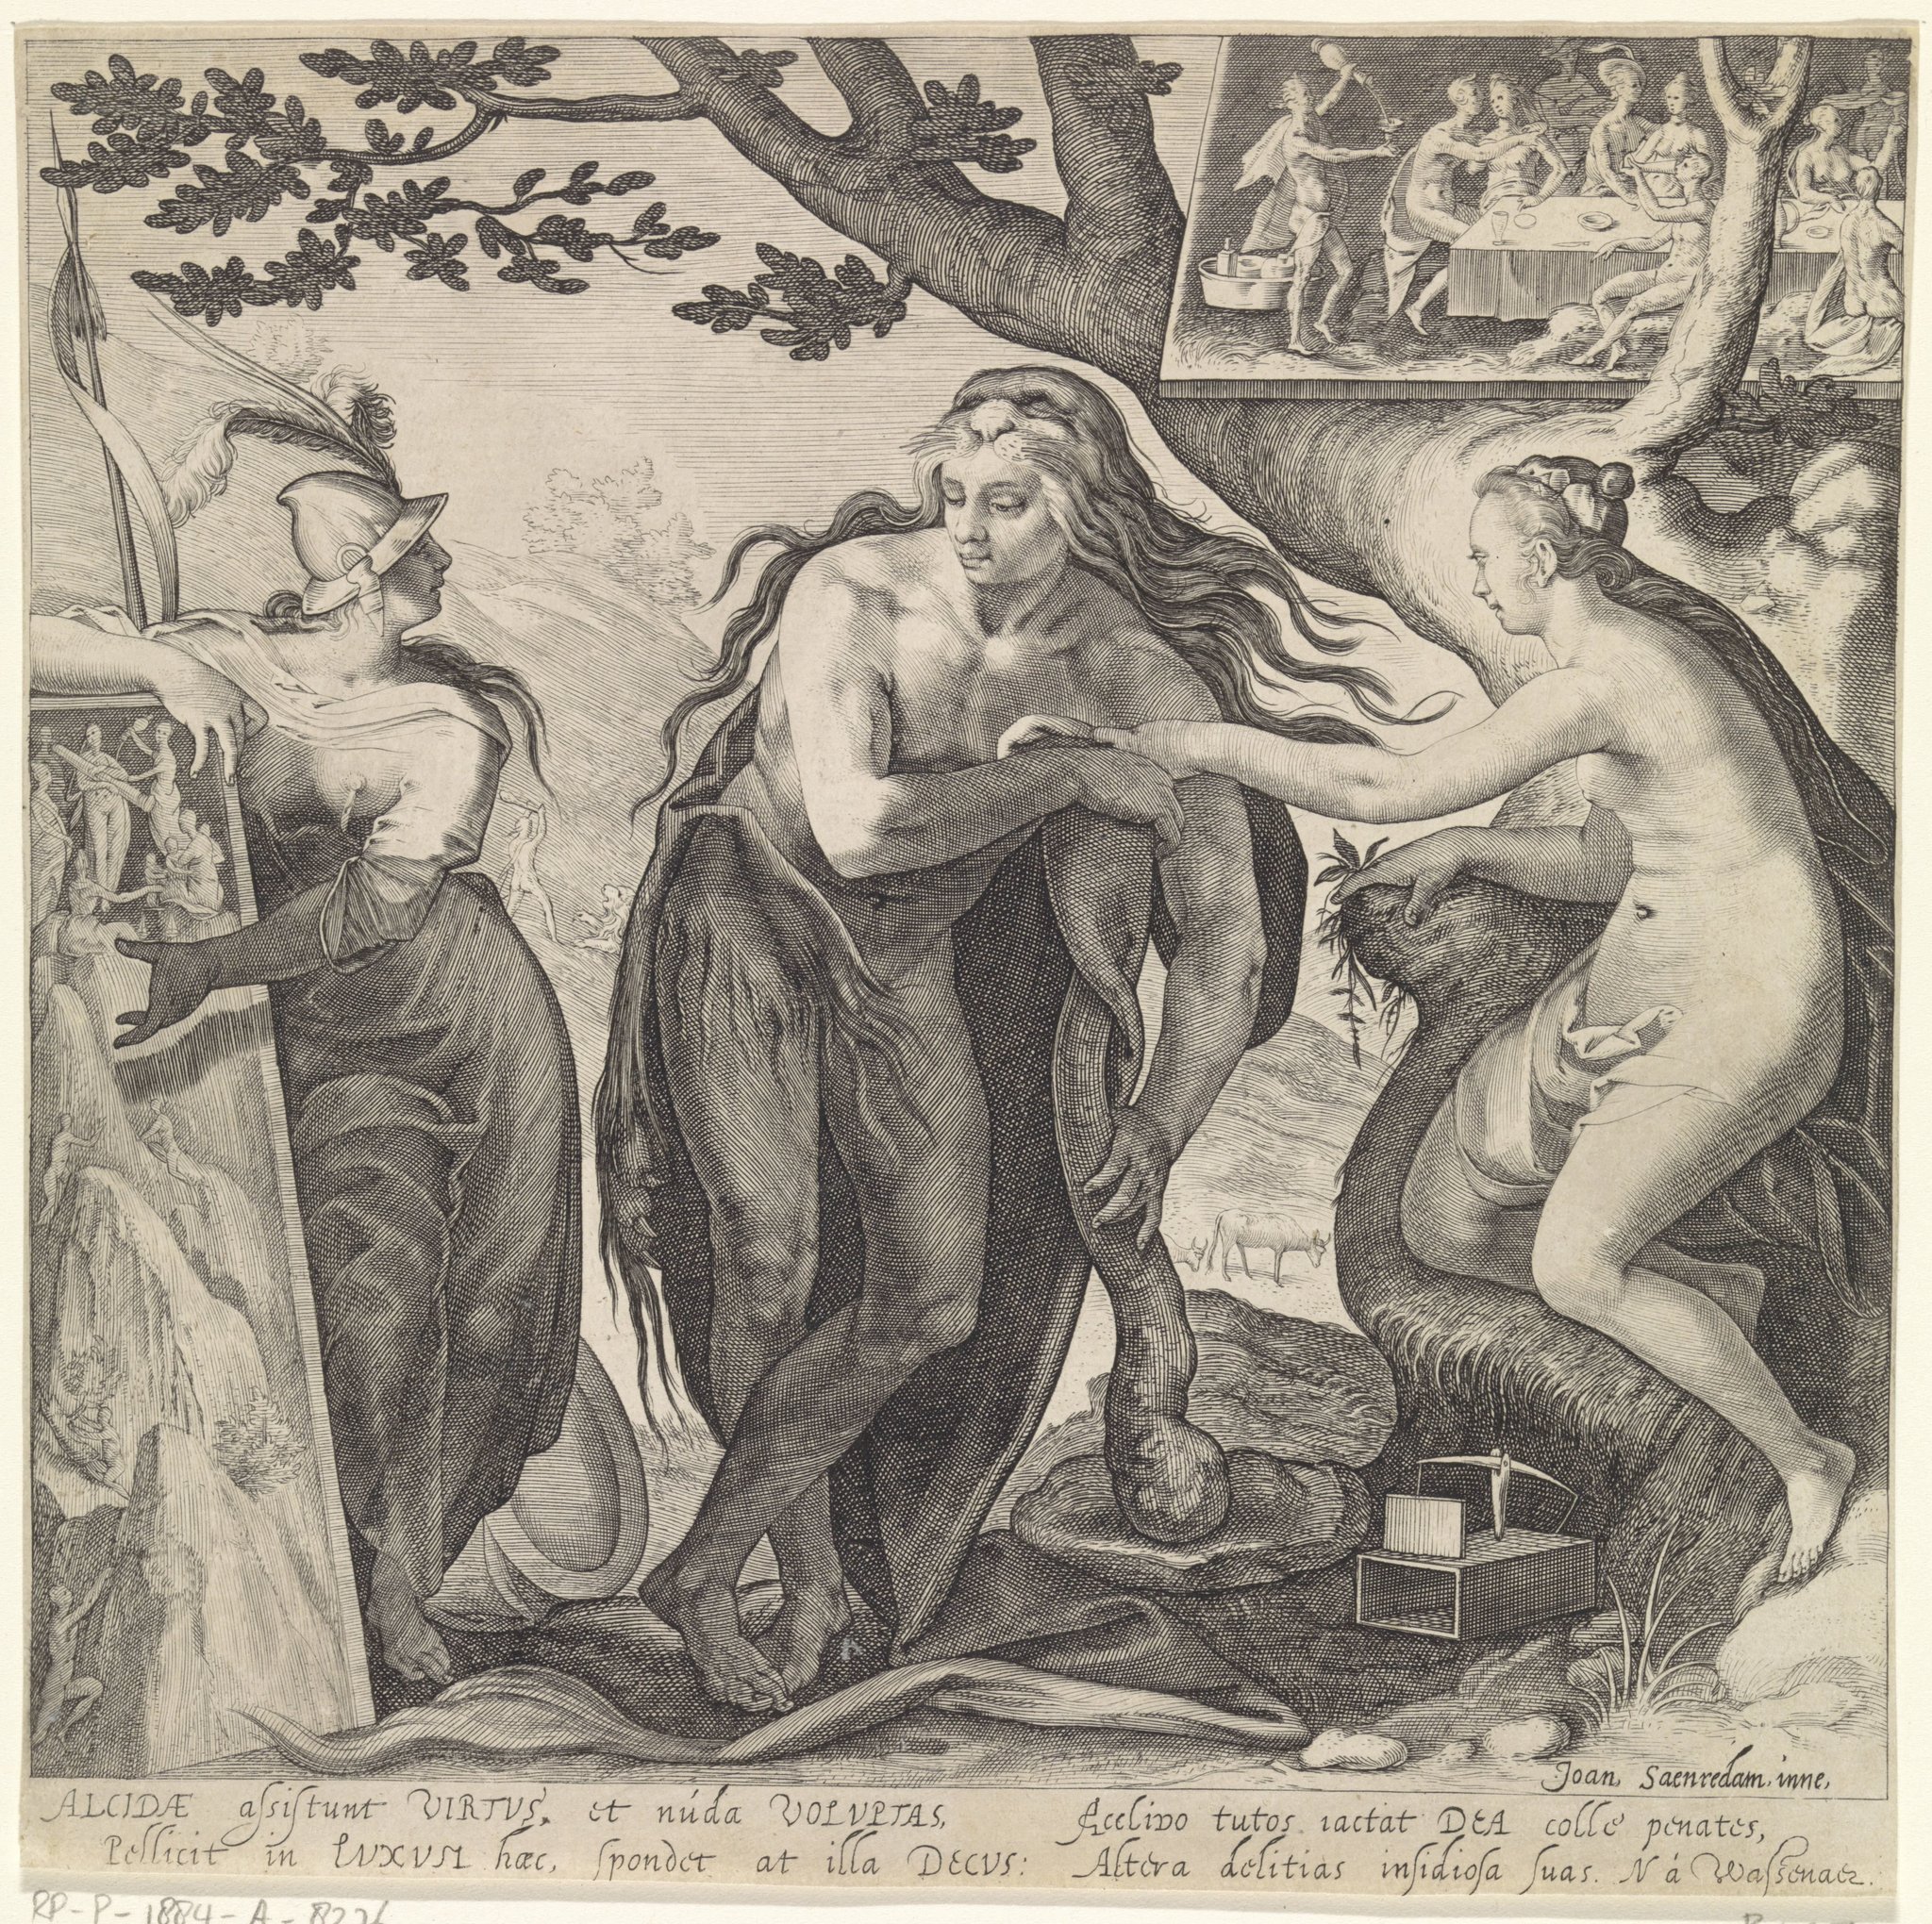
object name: print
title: Hercules op de tweesprong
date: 1589-1657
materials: paper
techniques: engraving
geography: northern netherlands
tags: hercules at the cross-roads, 'herkules am scheidewege': the choice of hercules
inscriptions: collector's mark: Lugt 2228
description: De jonge Hercules staat onder een boom en leunt op zijn knots. Hij moet kiezen tussen de Deugd en de Ondeugd. Deugd staat links. Ze draagt een lang gewaad en een helm. In haar hand houdt ze een speer. Ze wijst op een tableau met daarop het smalle, rotsachtige pad dat door verschillende personen wordt beklommen. Rechts zit de naakte Ondeugd. Ze houdt de hand van Hercules vast. Bij haar voeten staat een val. Boven haar een tableau met een overvloedig banket. Onder de voorstelling een vierregelige, Latijnse tekst met een beschrijving van de scène.